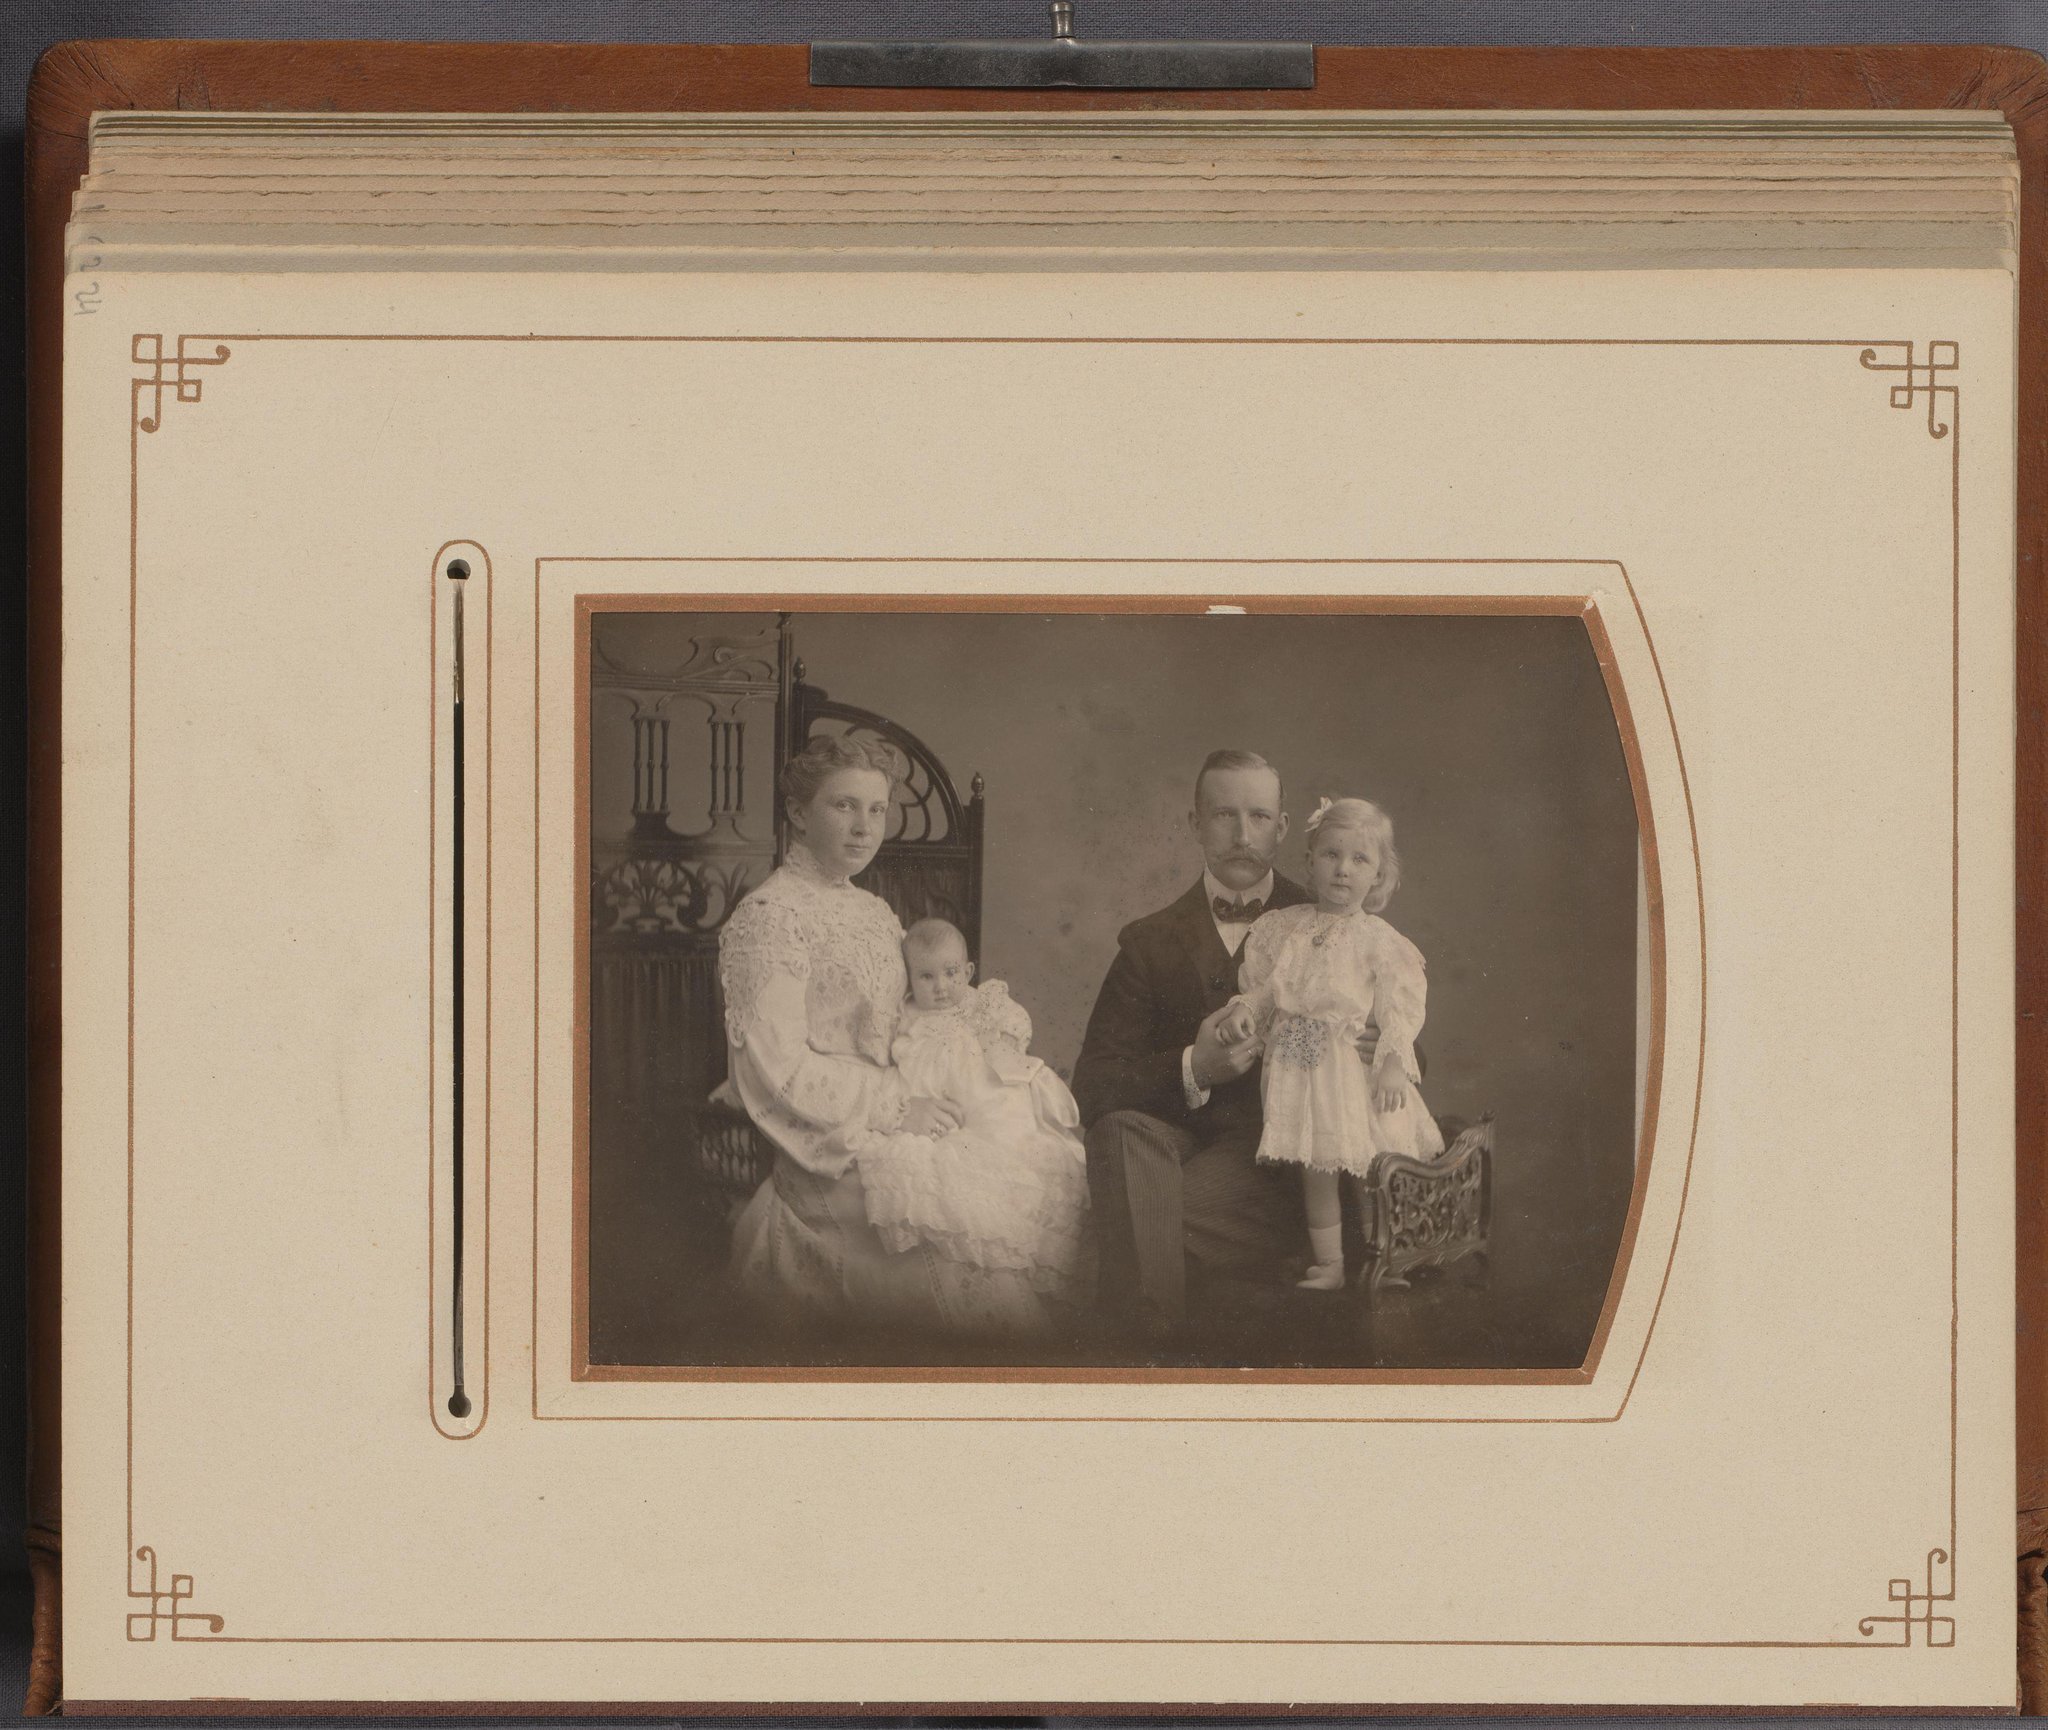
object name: album leaf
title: Familieportret met vader, moeder en twee kinderen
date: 1903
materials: cardboard, photographic support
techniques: collodion silver print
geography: bremen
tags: family group, especially parents with their child(ren)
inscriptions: annotation: ‘Odda u. Margot/ mit eltern/ 1903’, inscription: ‘Wolffram Comp./ Bemen/ 14 Fedelhören 14’